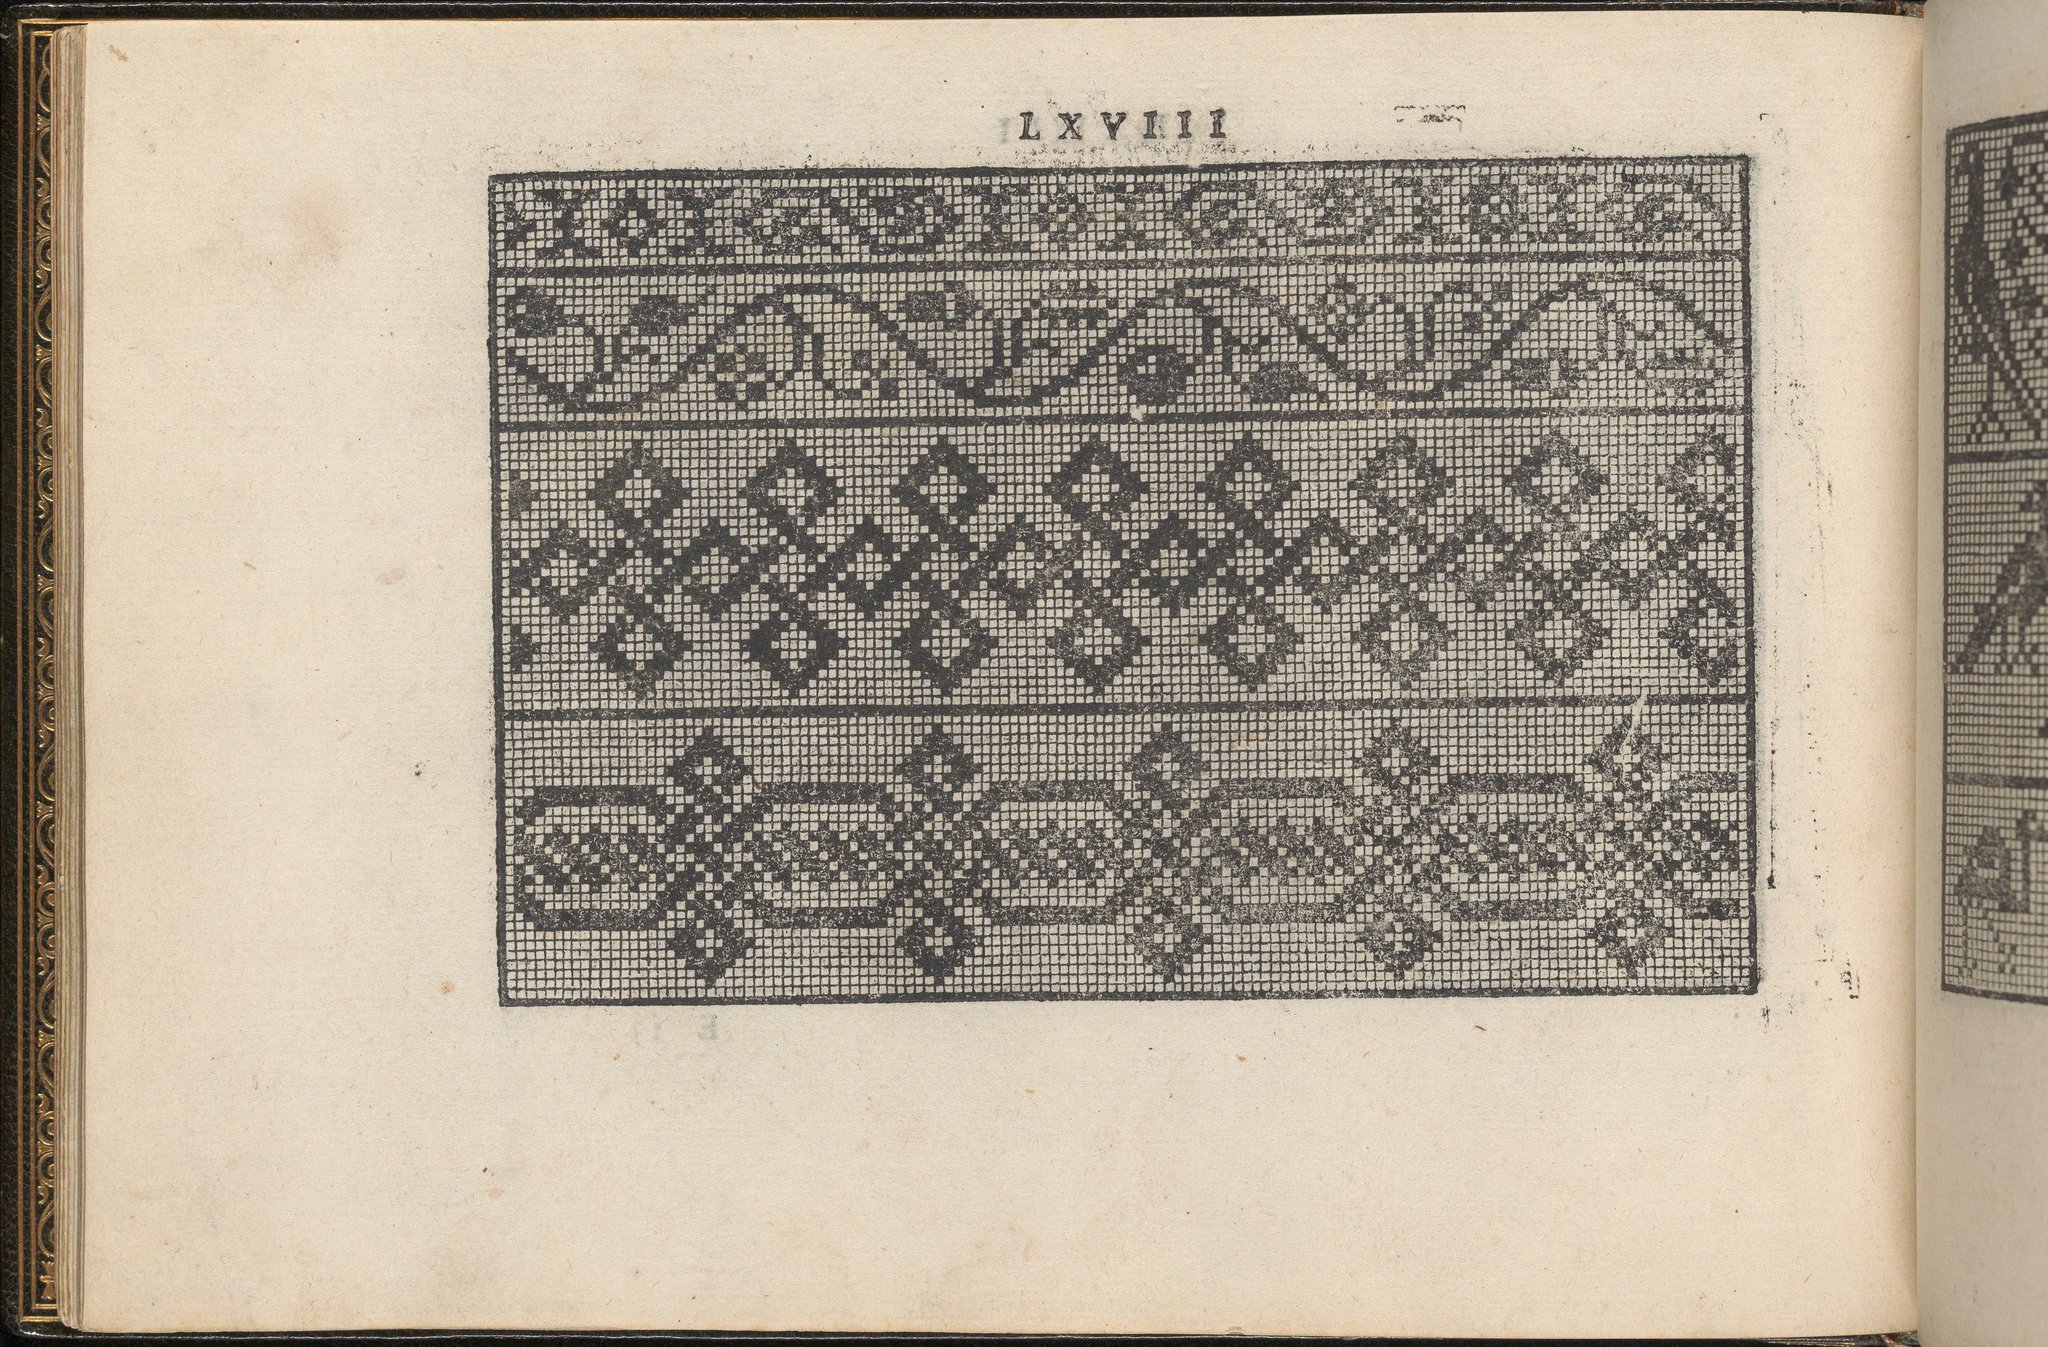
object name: book print ornament architecture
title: La Vera Perfettione del Disegno di varie sorti di recami, page 34 (verso)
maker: giovanni ostaus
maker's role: publisher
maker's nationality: italian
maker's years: 1507-1607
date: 1567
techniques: woodcut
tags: ornament